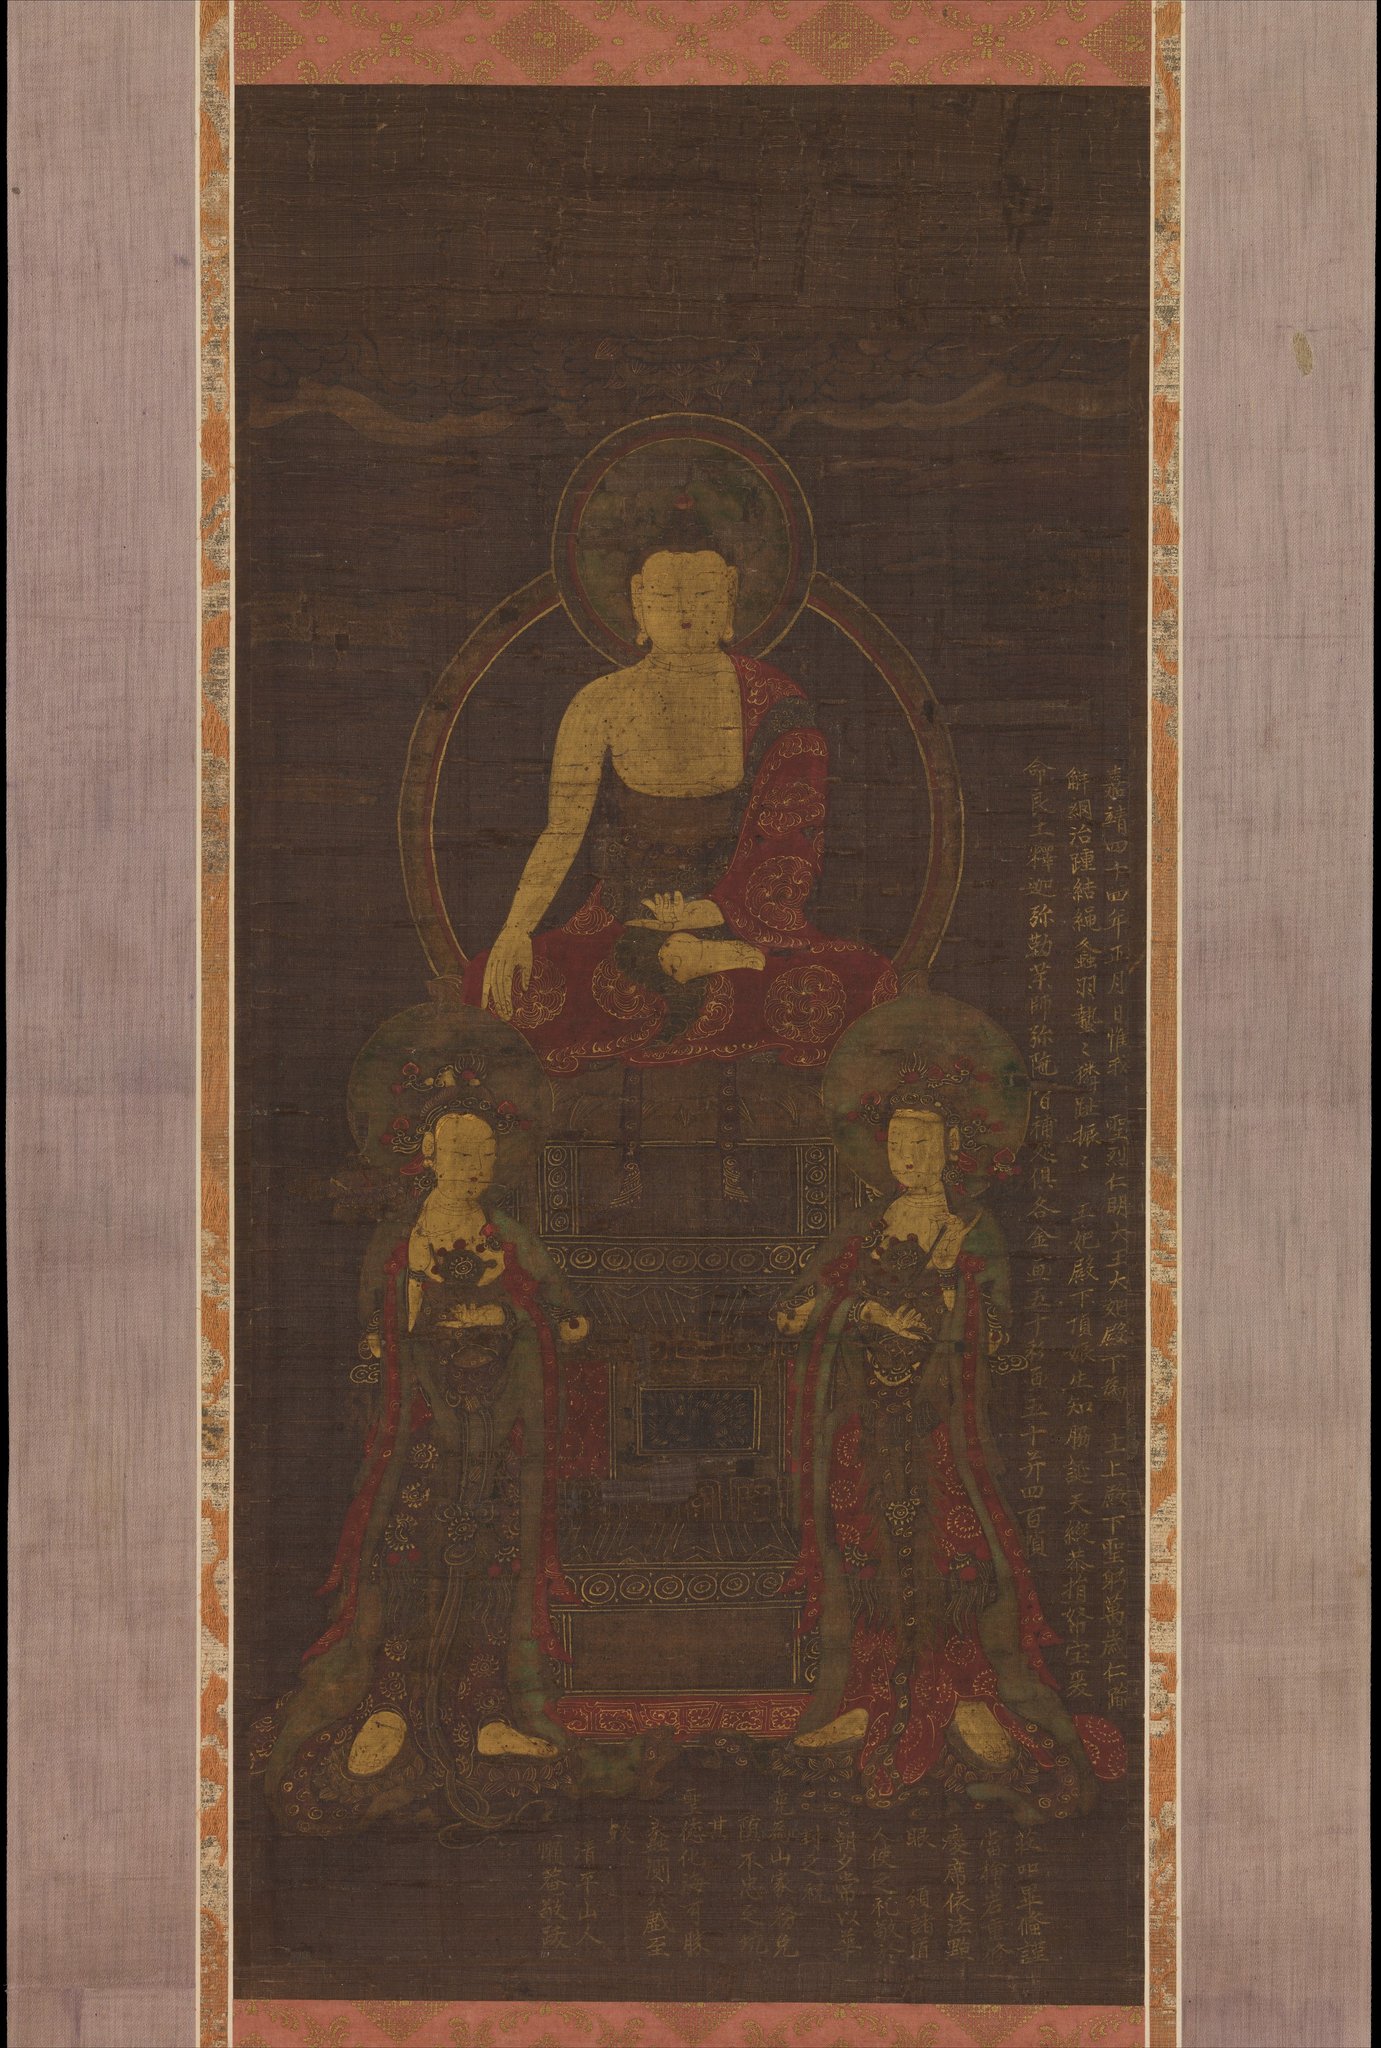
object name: hanging scroll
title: Shakyamuni triad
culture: korean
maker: unidentified artist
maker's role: artist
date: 1565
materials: gold, silk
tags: buddhism,bodhisattvas,buddha,shakyamuni